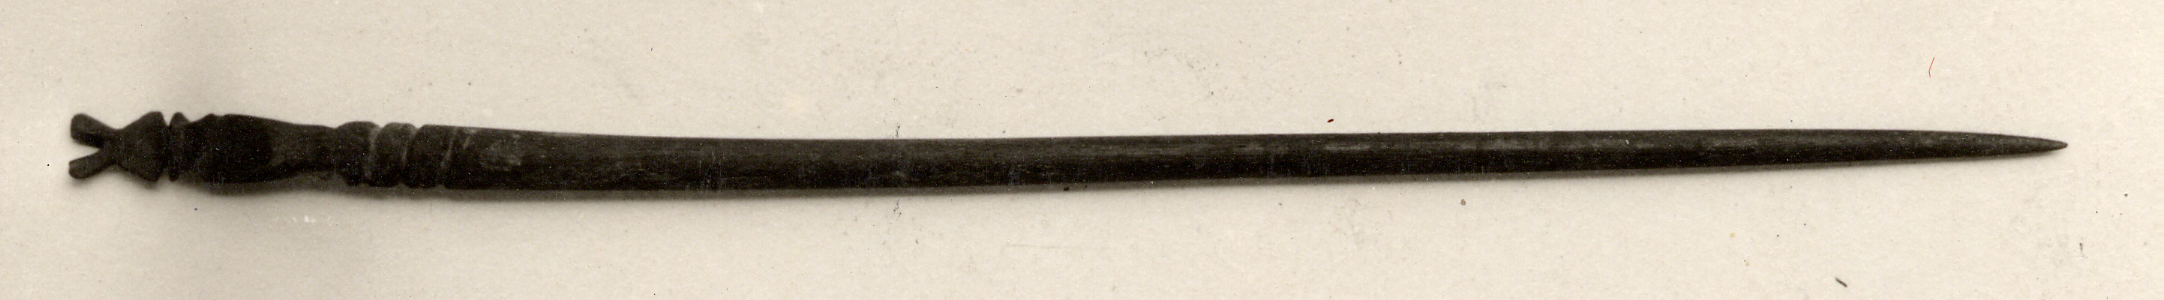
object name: hair pin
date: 1635-1458 BCE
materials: wood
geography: egypt